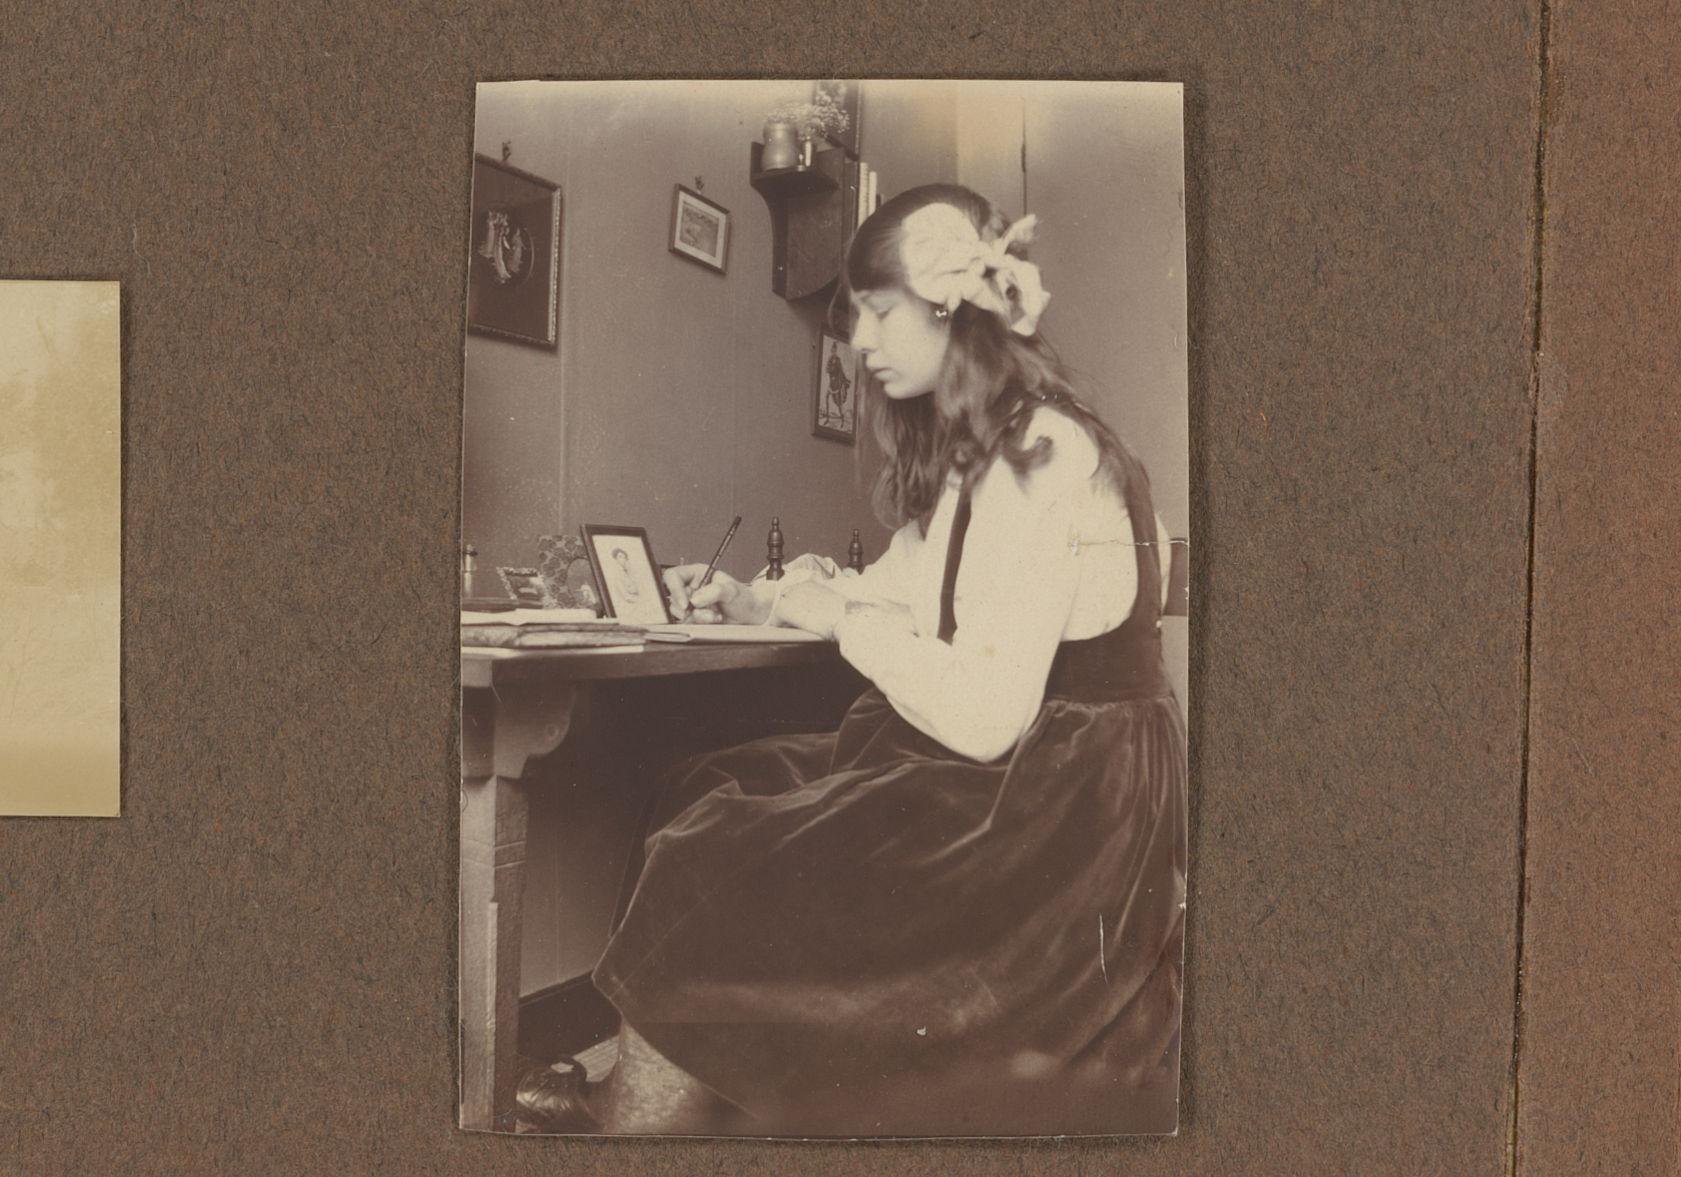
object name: photograph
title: Dochter van Diepenbrock aan een bureau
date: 1917-1925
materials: photographic support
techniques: photography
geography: amsterdam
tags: netherlands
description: Foto op bruin albumblad 48 van familiealbum van Alphons Diepenbrock.